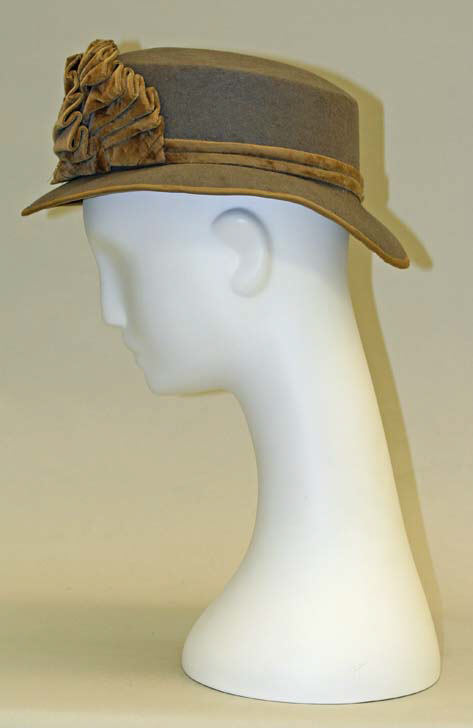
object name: hat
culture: american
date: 1869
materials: wool